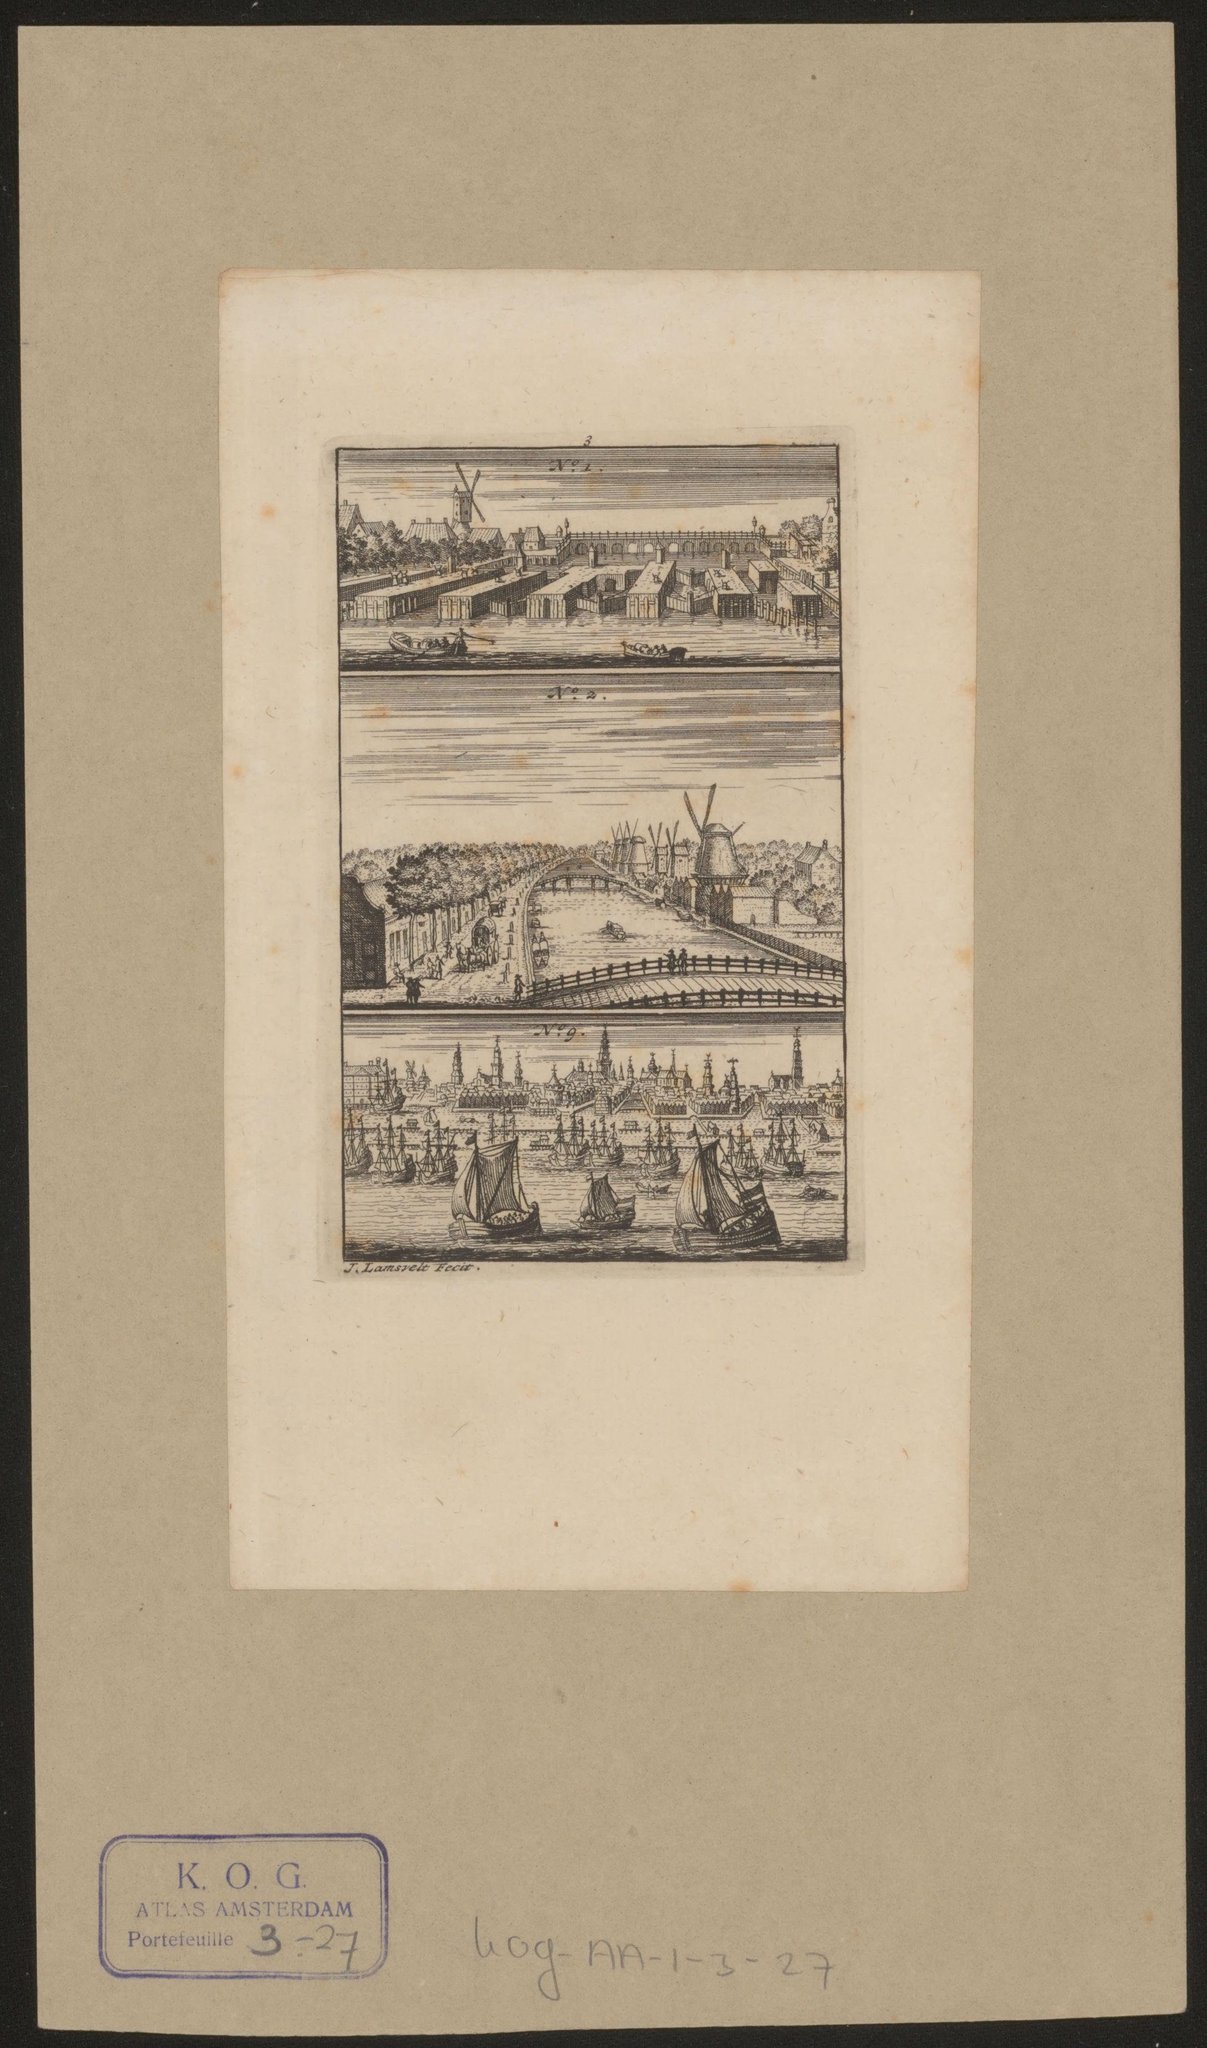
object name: print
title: Gezichten op Amsterdam vanaf het water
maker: jan lamsvelt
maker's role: print maker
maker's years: 1674-1743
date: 1696-1743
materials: paper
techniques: etching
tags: prospect of city, town panorama, silhouette of city, amsterdam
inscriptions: collector's mark: ‘3-27’ Lugt 1641b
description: Onderwerpsrubriek binnen de Atlas Amsterdam: Panorama's en verzamelprenten. Genummerd: 3.